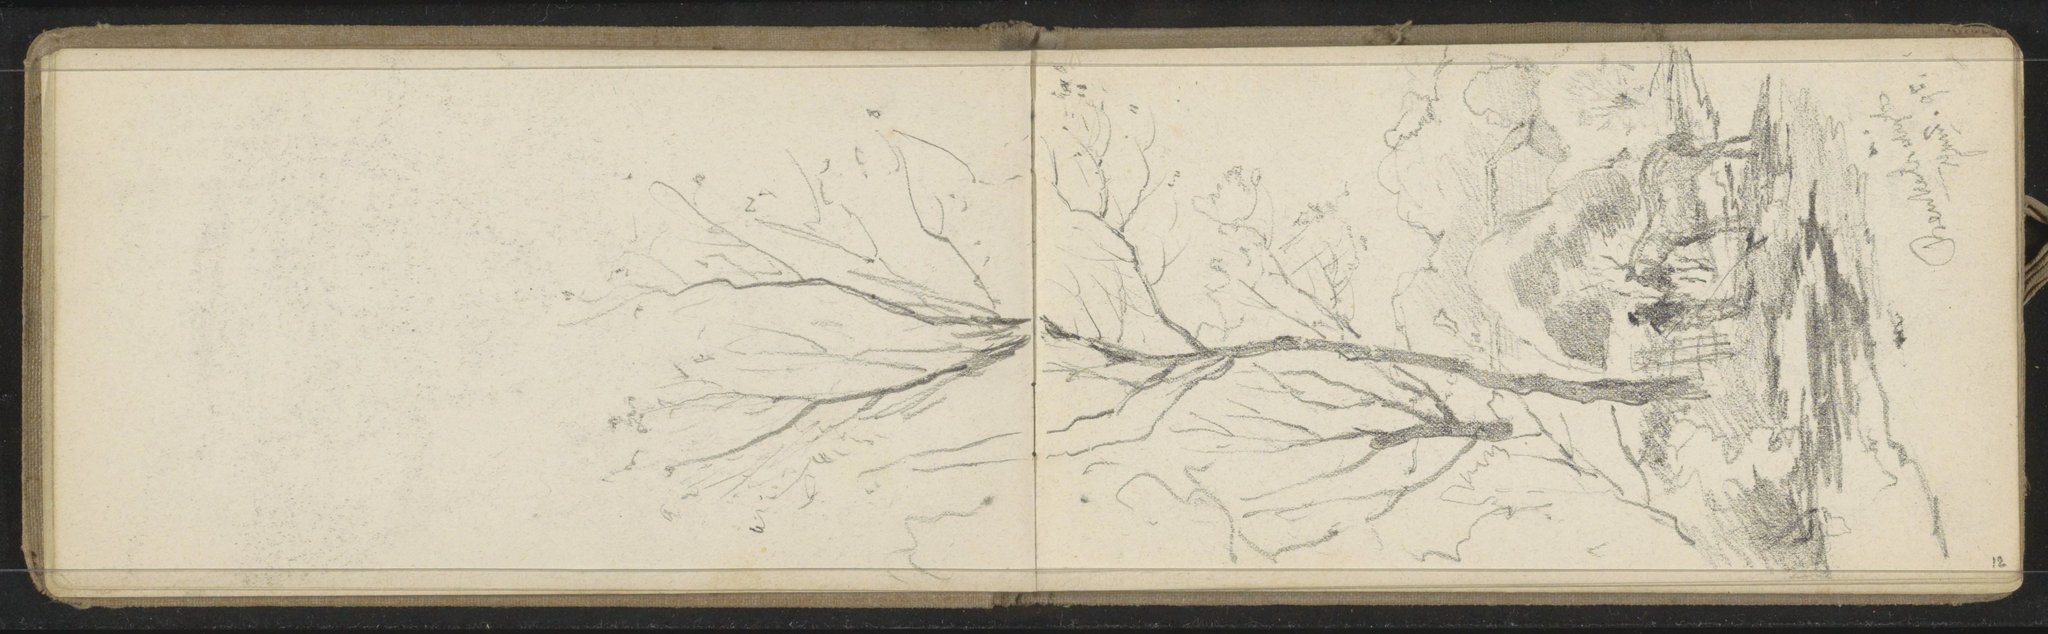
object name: sketchbook leaf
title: Man met paard op de Beukelsdijk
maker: willem cornelis rip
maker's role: draughtsman, painter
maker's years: 1856-1922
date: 1806-1895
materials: paper, pencil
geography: delfshaven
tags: horse, landscapes (+ landscape with figures, staffage)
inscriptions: date and inscription: ‘Beukelsdijk/ Jun[...] 95.’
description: Blad 11 verso en 12 recto uit een schetsboek met 39 bladen.